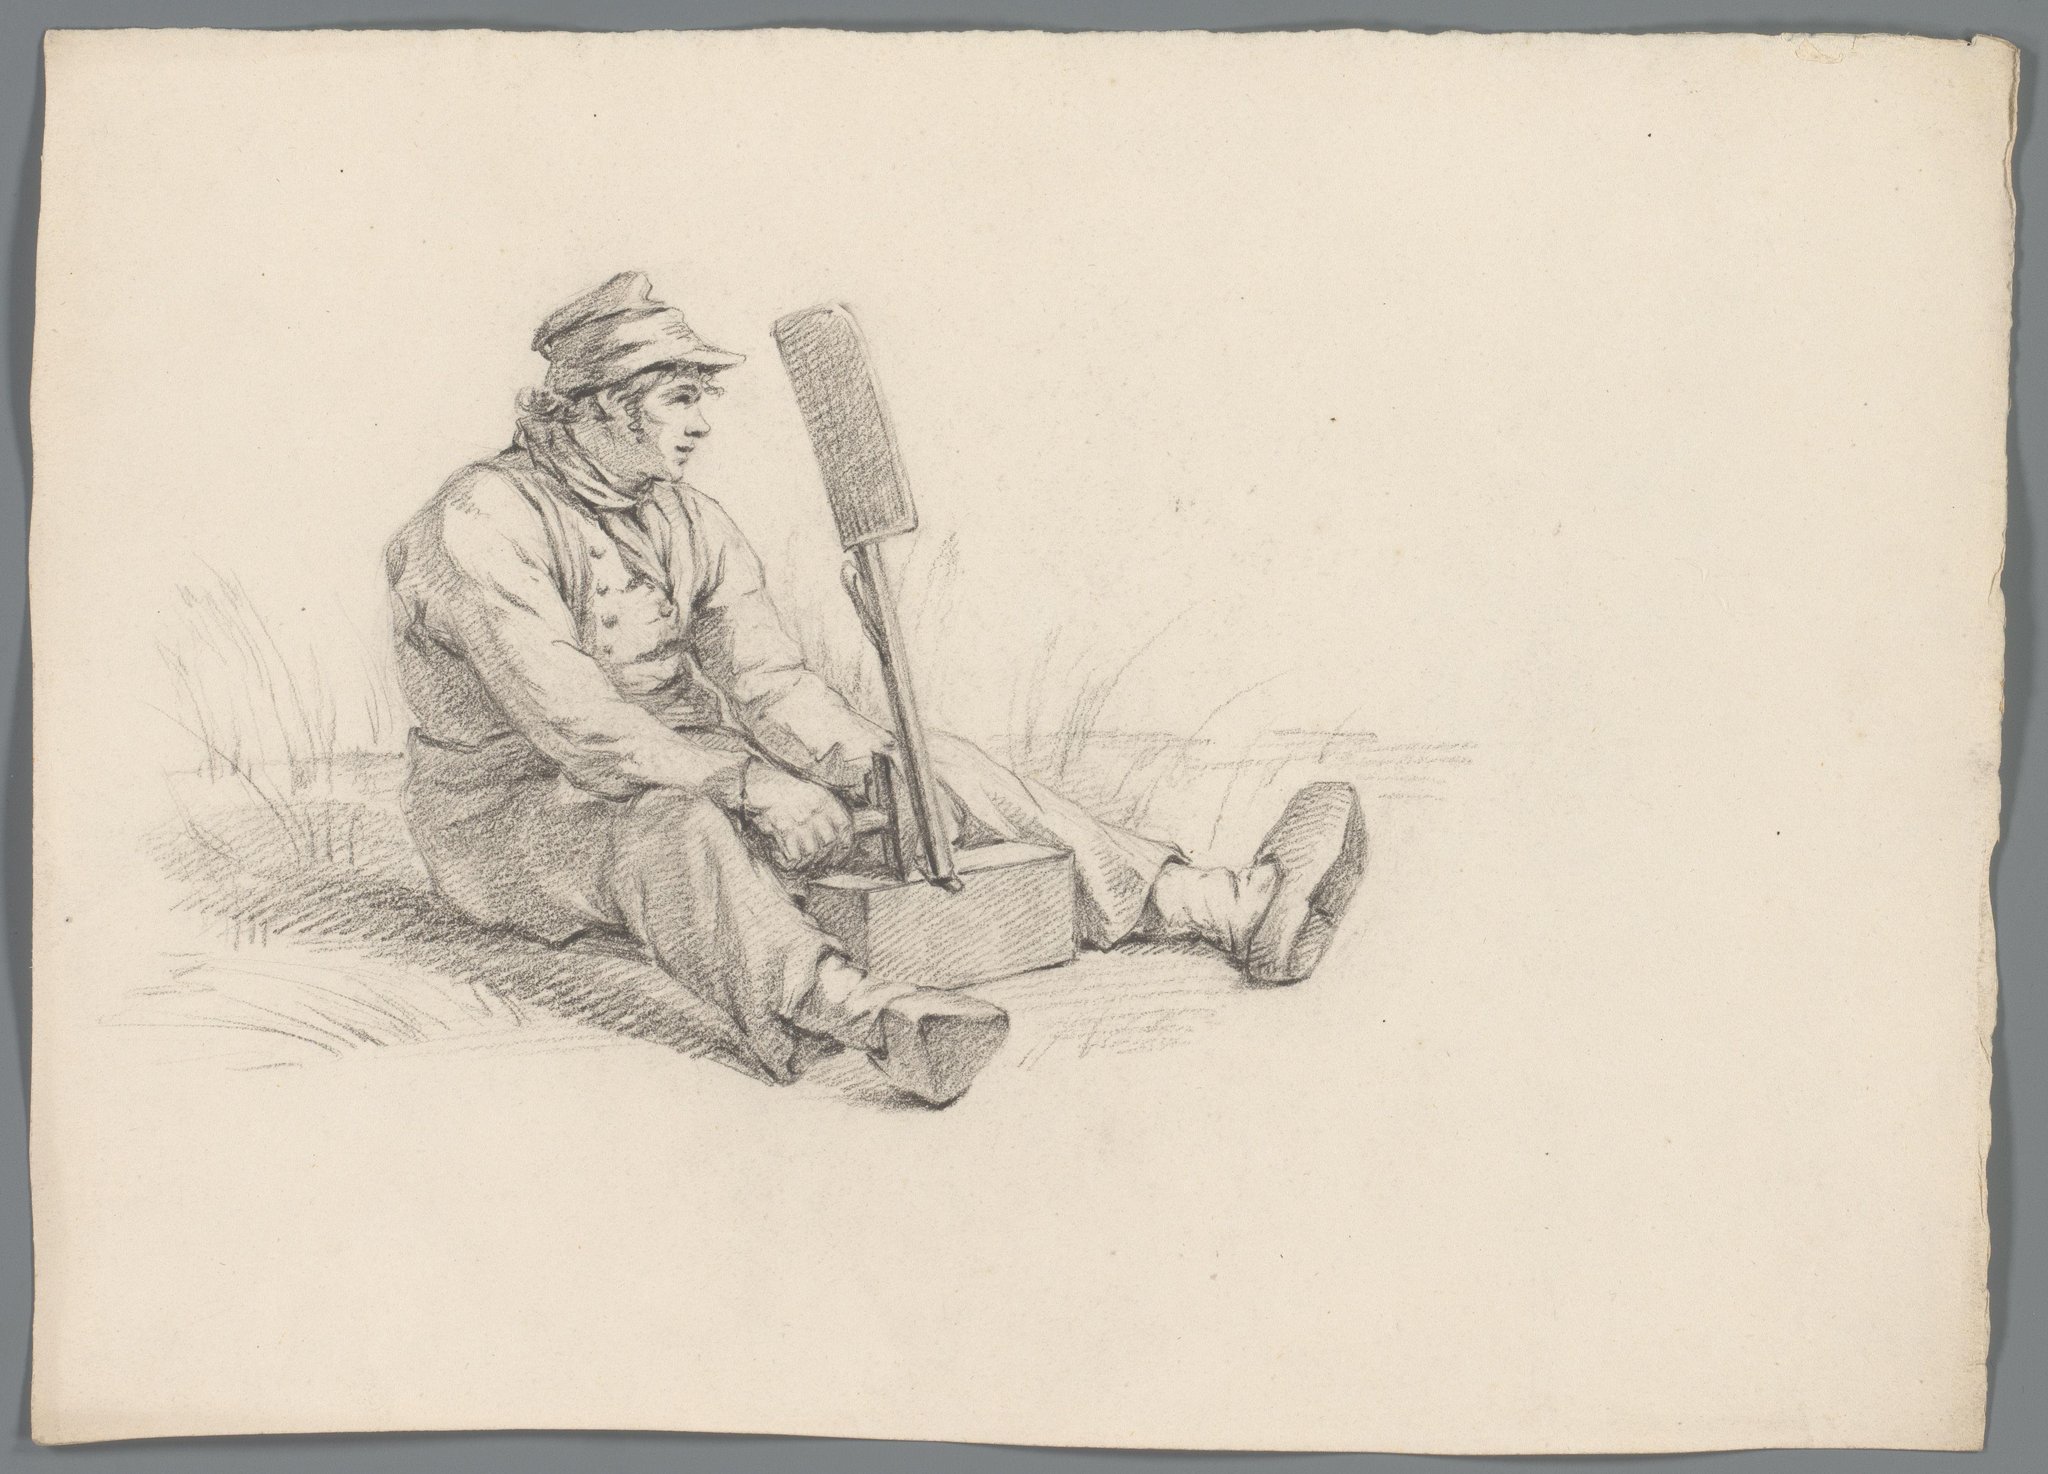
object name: drawing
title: Man bewerkt een blok met een hamer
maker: Anonymous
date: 1820-1830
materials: chalk, paper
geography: the hague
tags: tools, aids, implements ~ crafts and industries, wooden shoes, clogs, adult man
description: Tekeningen waarschijnlijk ontstaan bij het Haagse kunstgenootschap ‘Tot Nut der Tekenkunst’, waar twee keer per week tekenavonden werden georganiseerd met geklede modellen.